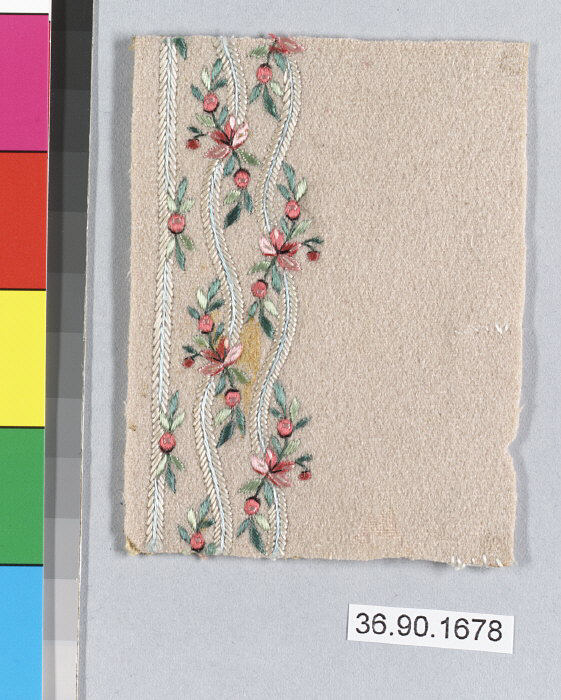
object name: sample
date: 1801-1833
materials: felt, silk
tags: flowers